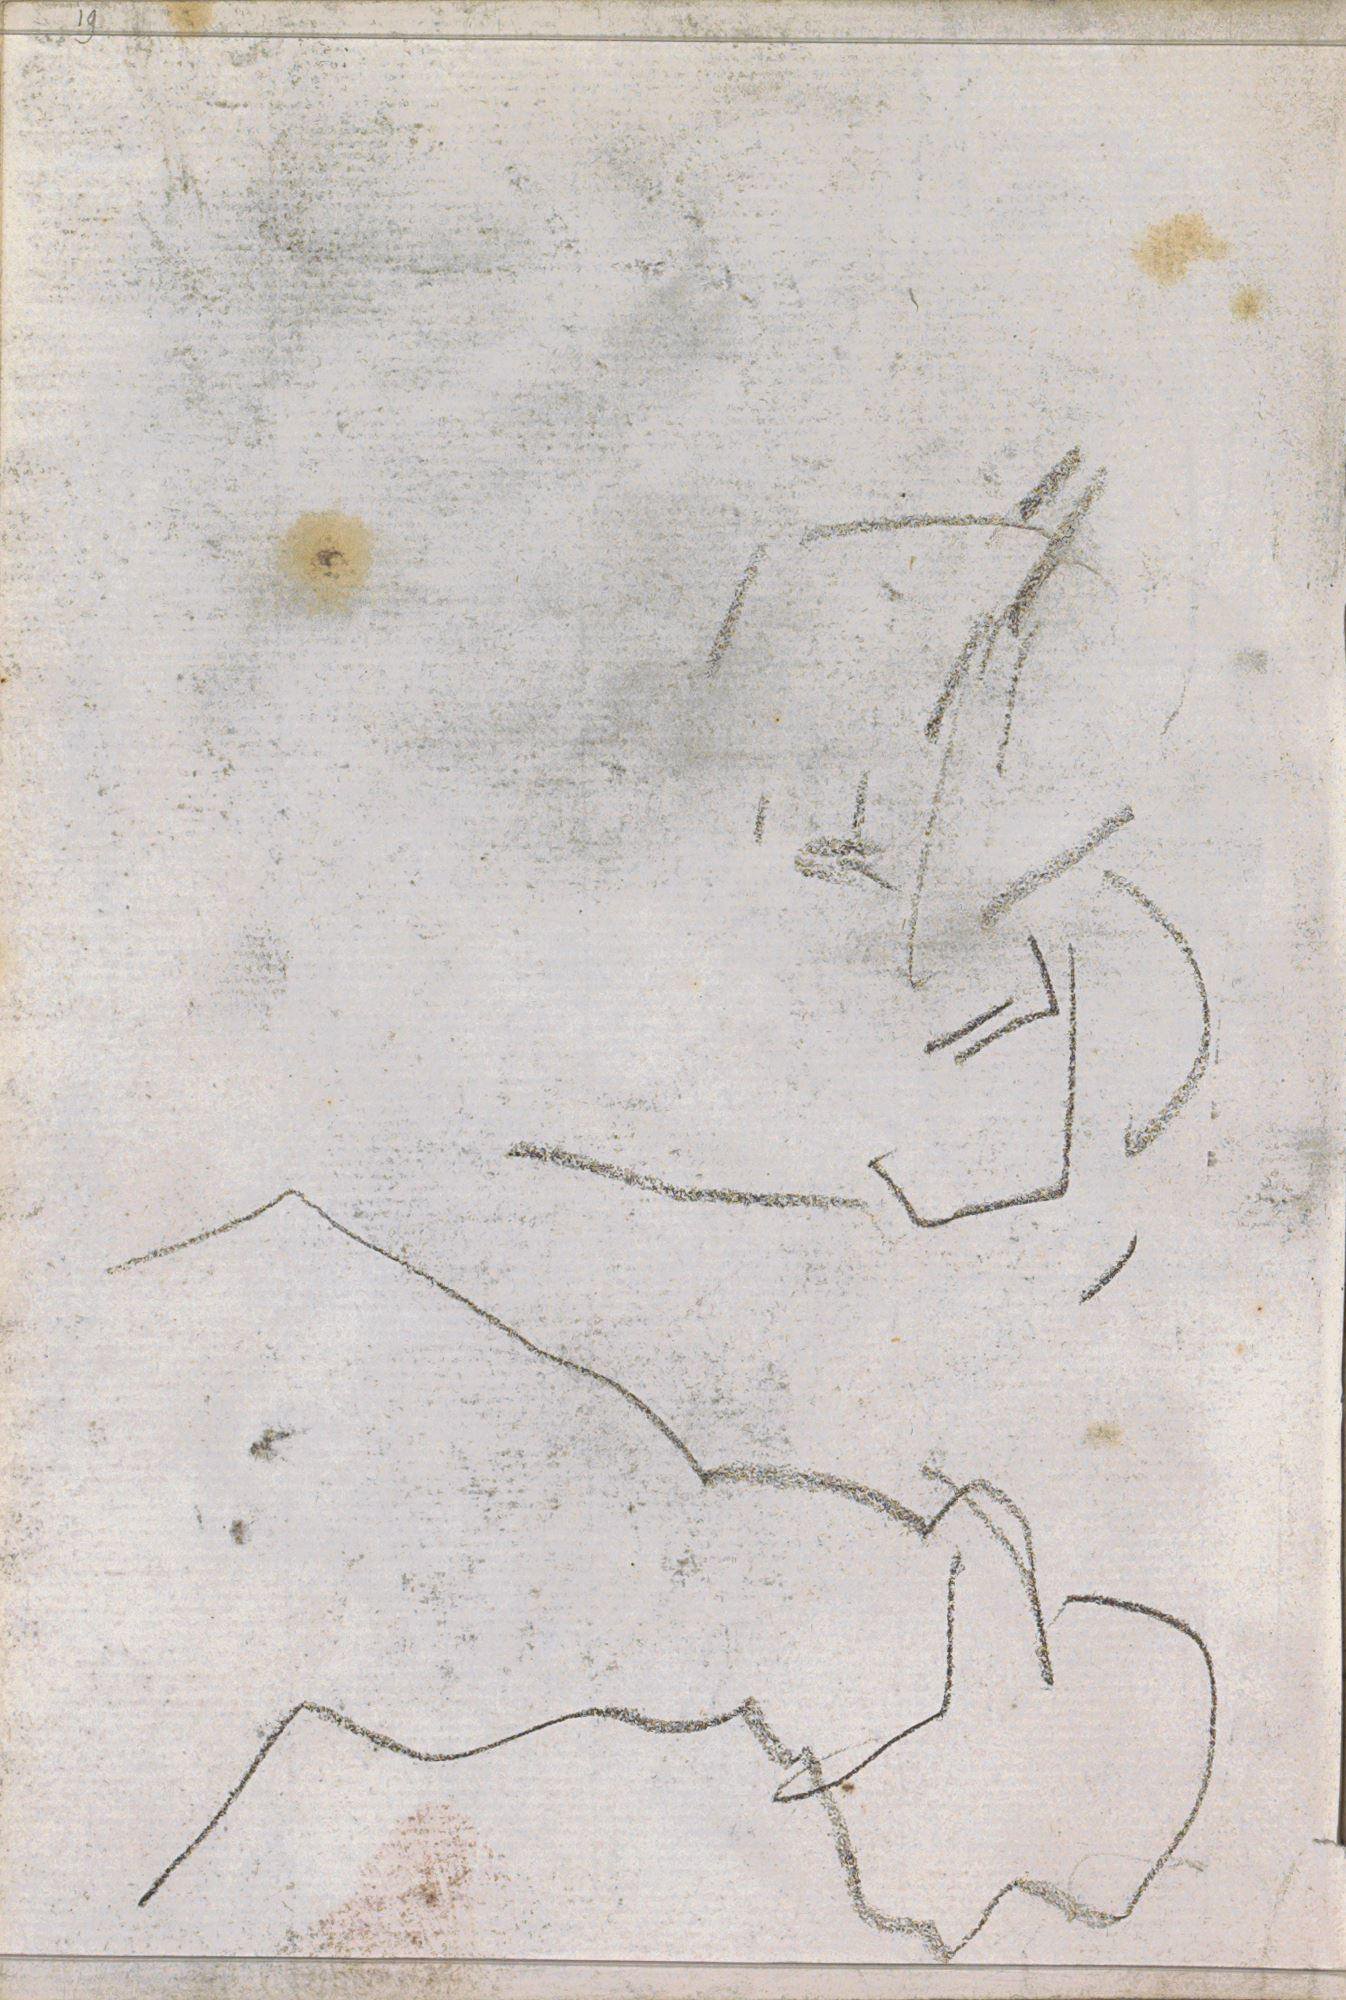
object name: sketchbook leaf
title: Figuurstudies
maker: isaac israels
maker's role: draughtsman, painter, print maker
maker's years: 1865-1934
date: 1875-1934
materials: chalk, paper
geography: the hague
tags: the (nude) human figure; 'corpo humano' (ripa)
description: Pagina 19 uit schetsboek XLIV met 43 pagina's.